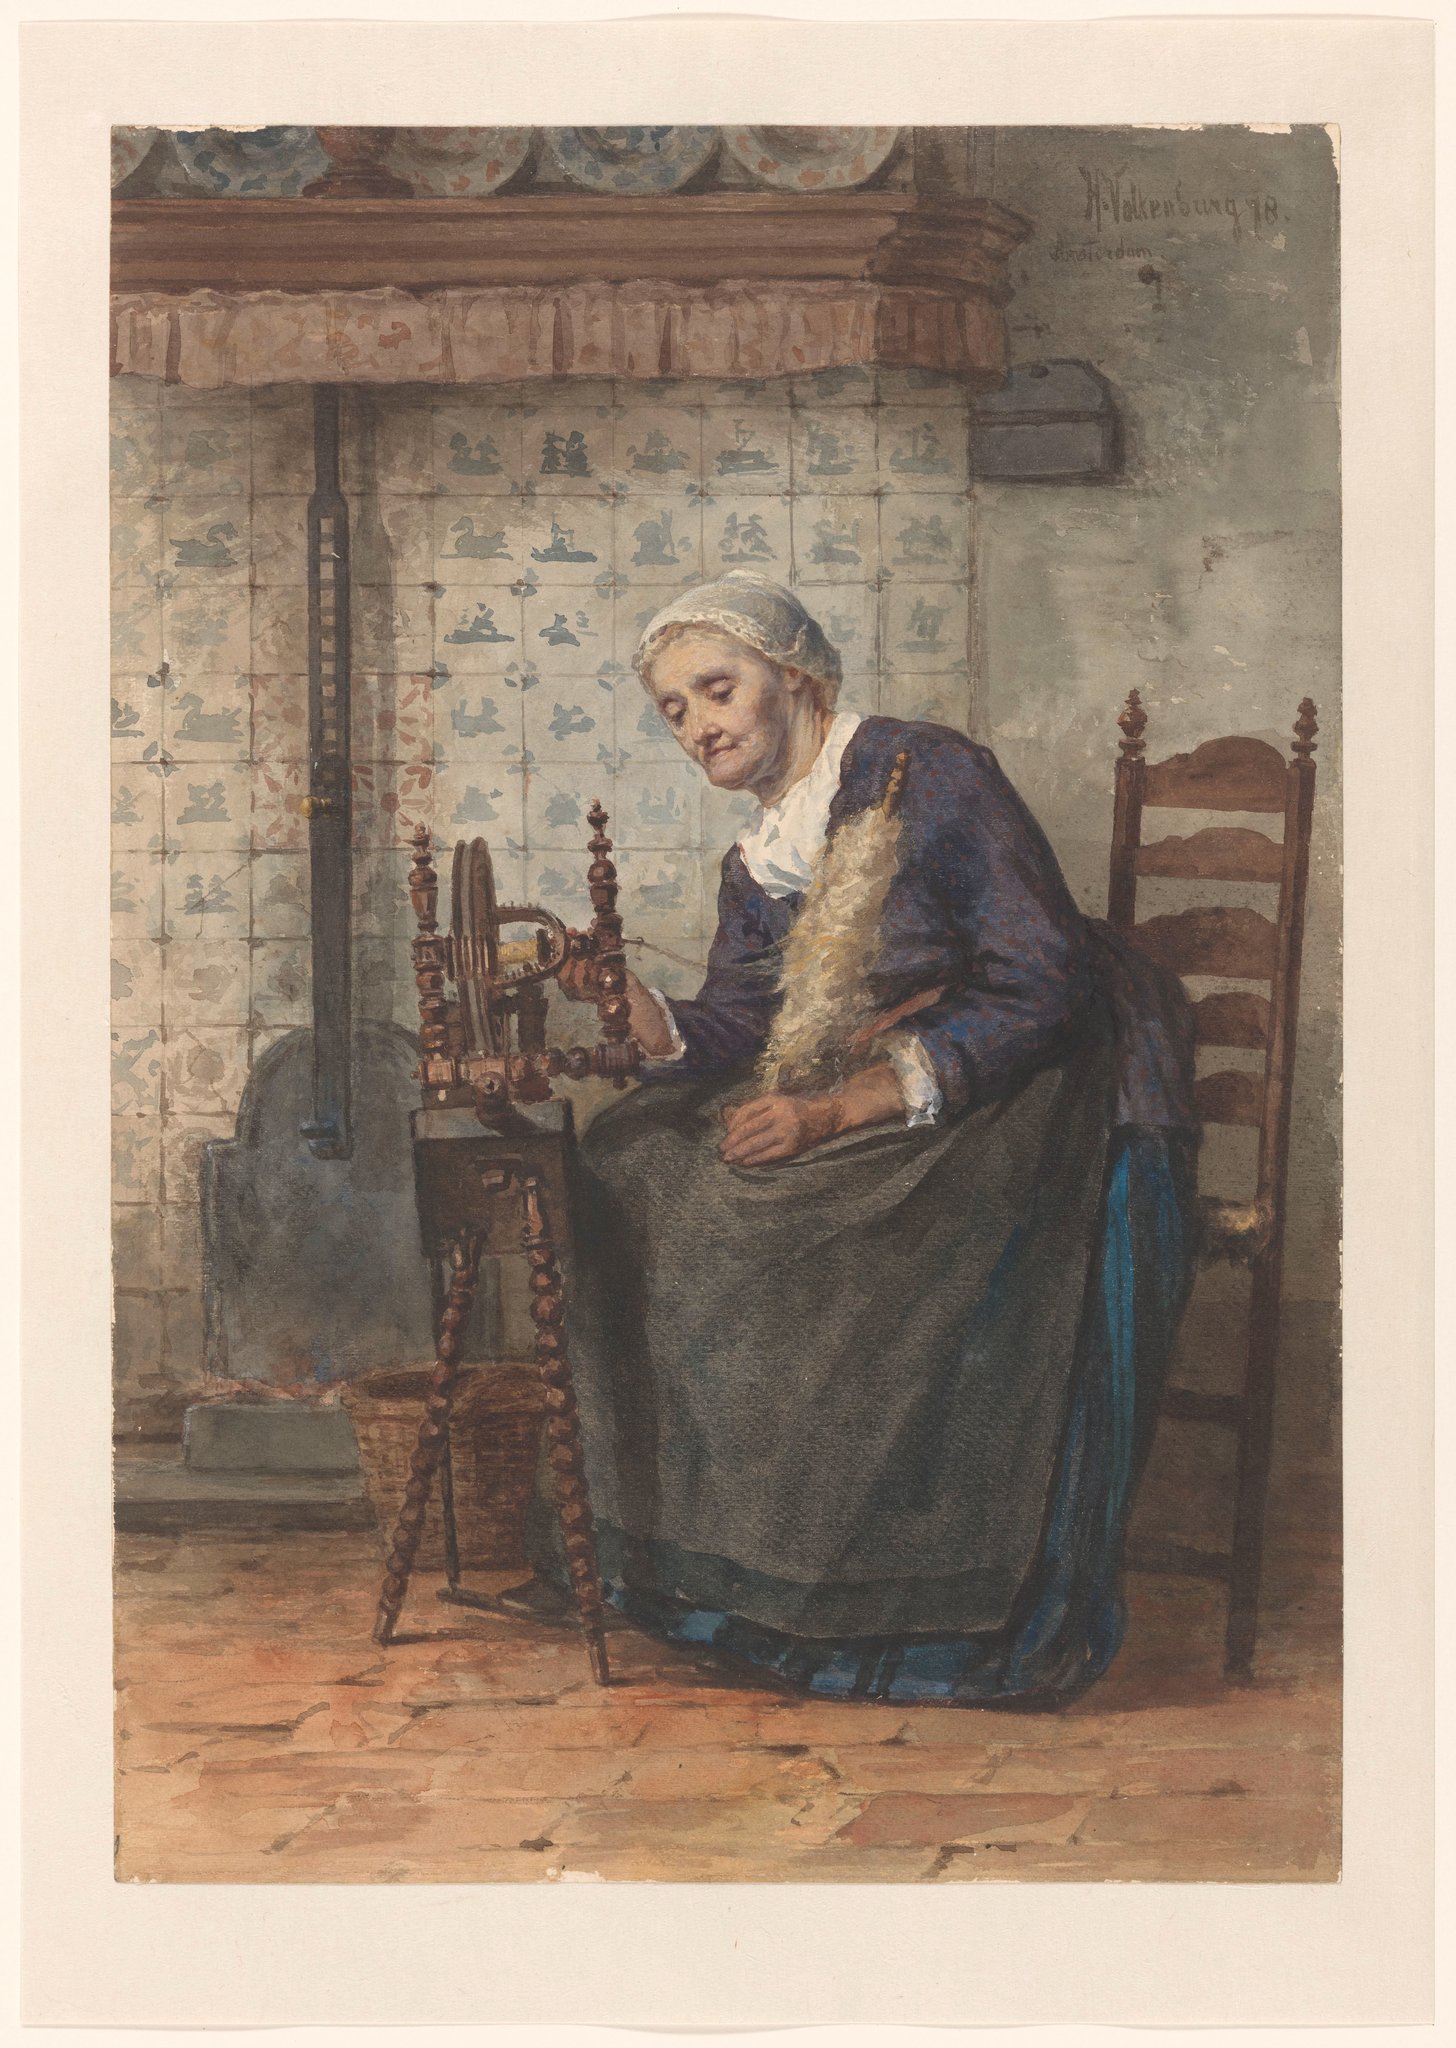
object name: watercolor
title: Oude vrouw in interieur aan spinnewiel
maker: hendrik valkenburg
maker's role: draughtsman, painter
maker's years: 1826-1896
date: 1878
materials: paper, watercolor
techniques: brush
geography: amsterdam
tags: old woman, interior of the house, spinning (manufacture of yarn)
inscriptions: date